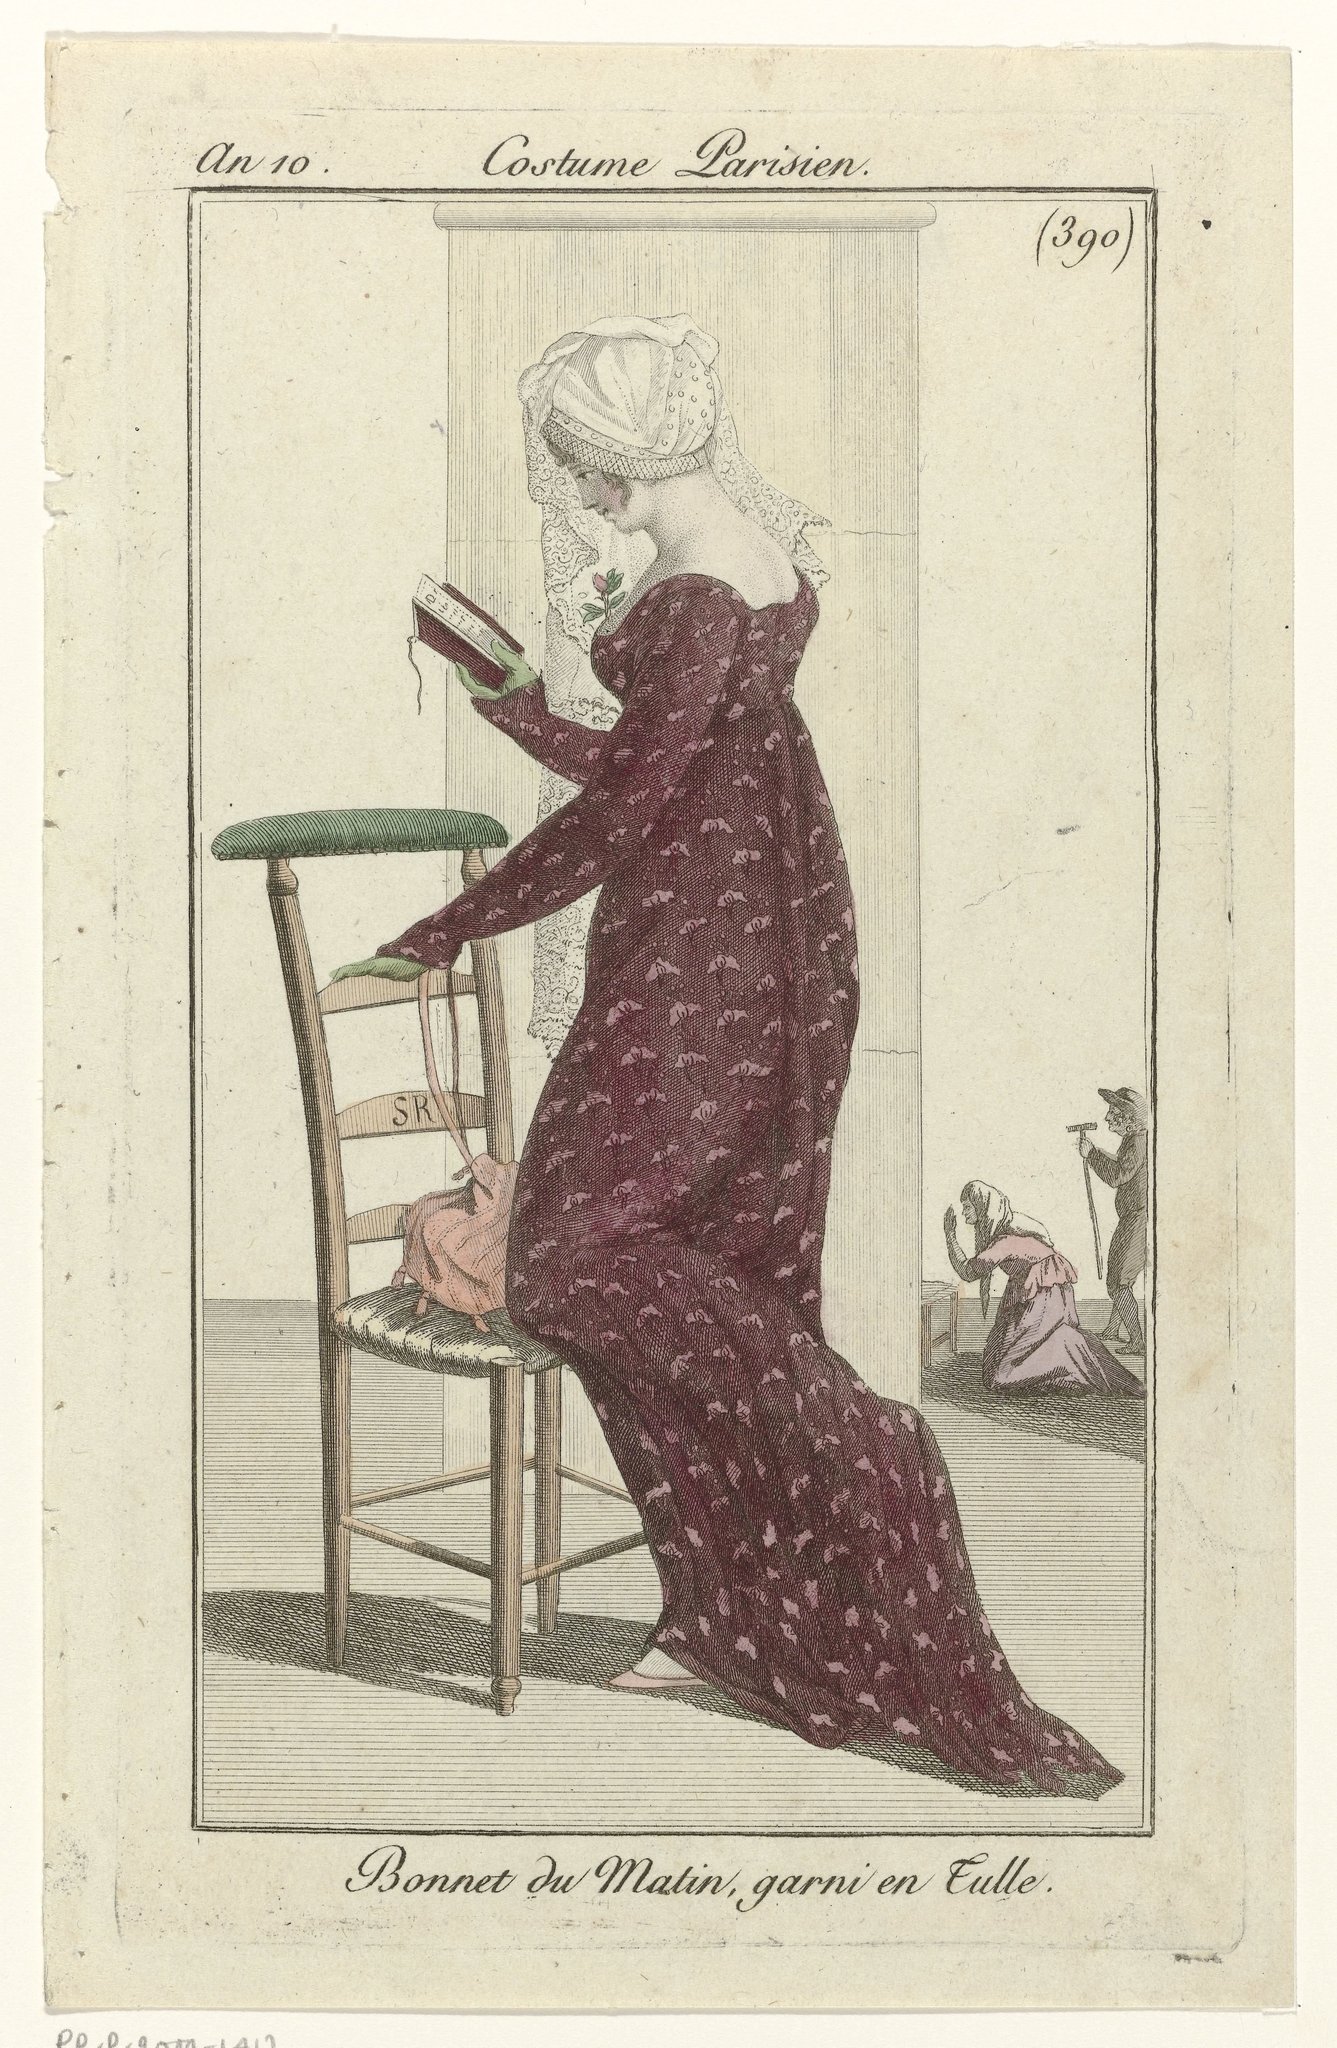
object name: fashion print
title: Journal des Dames et des Modes: Ladies’ Fashion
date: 1802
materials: paper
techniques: engraving, hand coloring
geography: paris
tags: corsage (+ women's clothes), kneeling-chair, gloves, mittens (long gloves) (+ women's clothes), veil (+ women's clothes), bag (reticule) (+ women's clothes), head-gear: morning cap (+ women's clothes), fashion plates, shoes, sandals (+ women's clothes), dress, gown (+ women's clothes), book - mm - book open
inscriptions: title: ‘Costume Parisien.’, caption: ‘Bonnet du Matin, garni en Tulle’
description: After the turbulent years of the French Revolution, in 1797 a fashion magazine was finally published again: the Journal des Dames et des Modes. Under the direction of Pierre de La Mésangère, it developed a cosmopolitan flair. The very best draughtsmen were recruited to produce the fashion illustrations, called Costumes Parisiens. They visited spots all over Paris to ensure they saw the latest styles. These included high-waisted gowns with low necklines, ‘Greek’ slippers with cross-laces 1, genuine Kashmiri shawls 2, reticules 3 (small stylish handbags), poke bonnets 4 and full-length English coats knowns as redingotes 5.